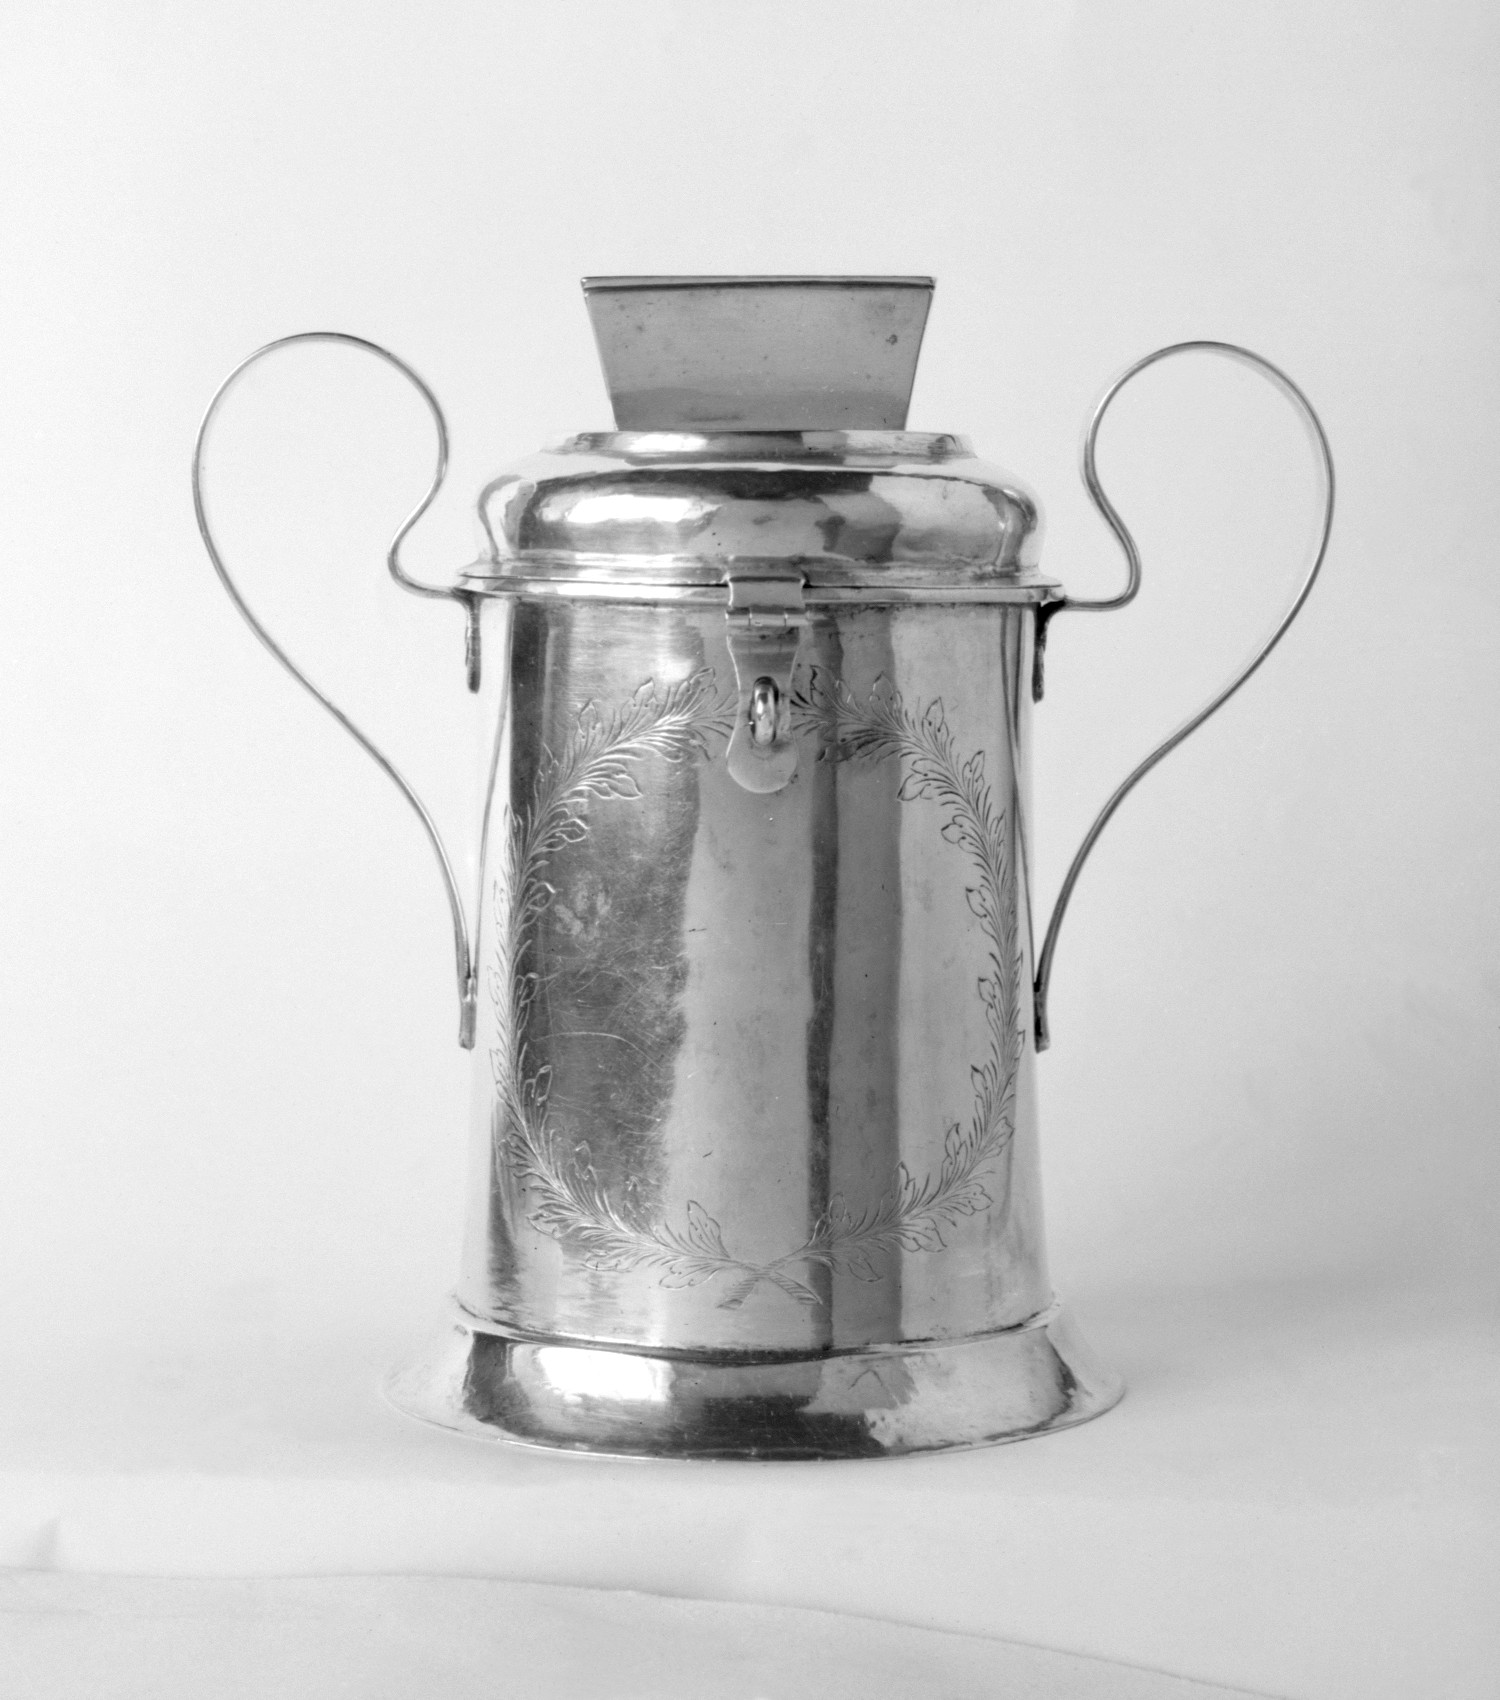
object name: alms box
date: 1767-1833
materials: silver